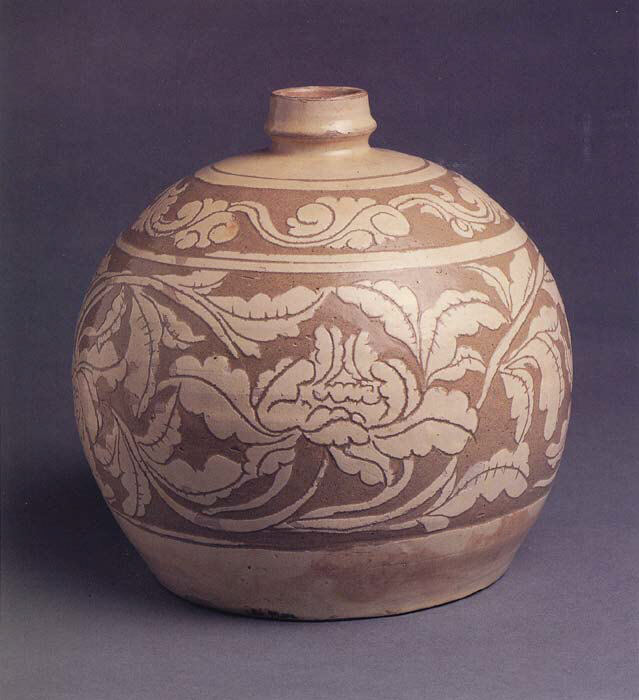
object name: bottle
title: Bottle decorated with peonies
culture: chinese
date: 1201-1333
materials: stoneware